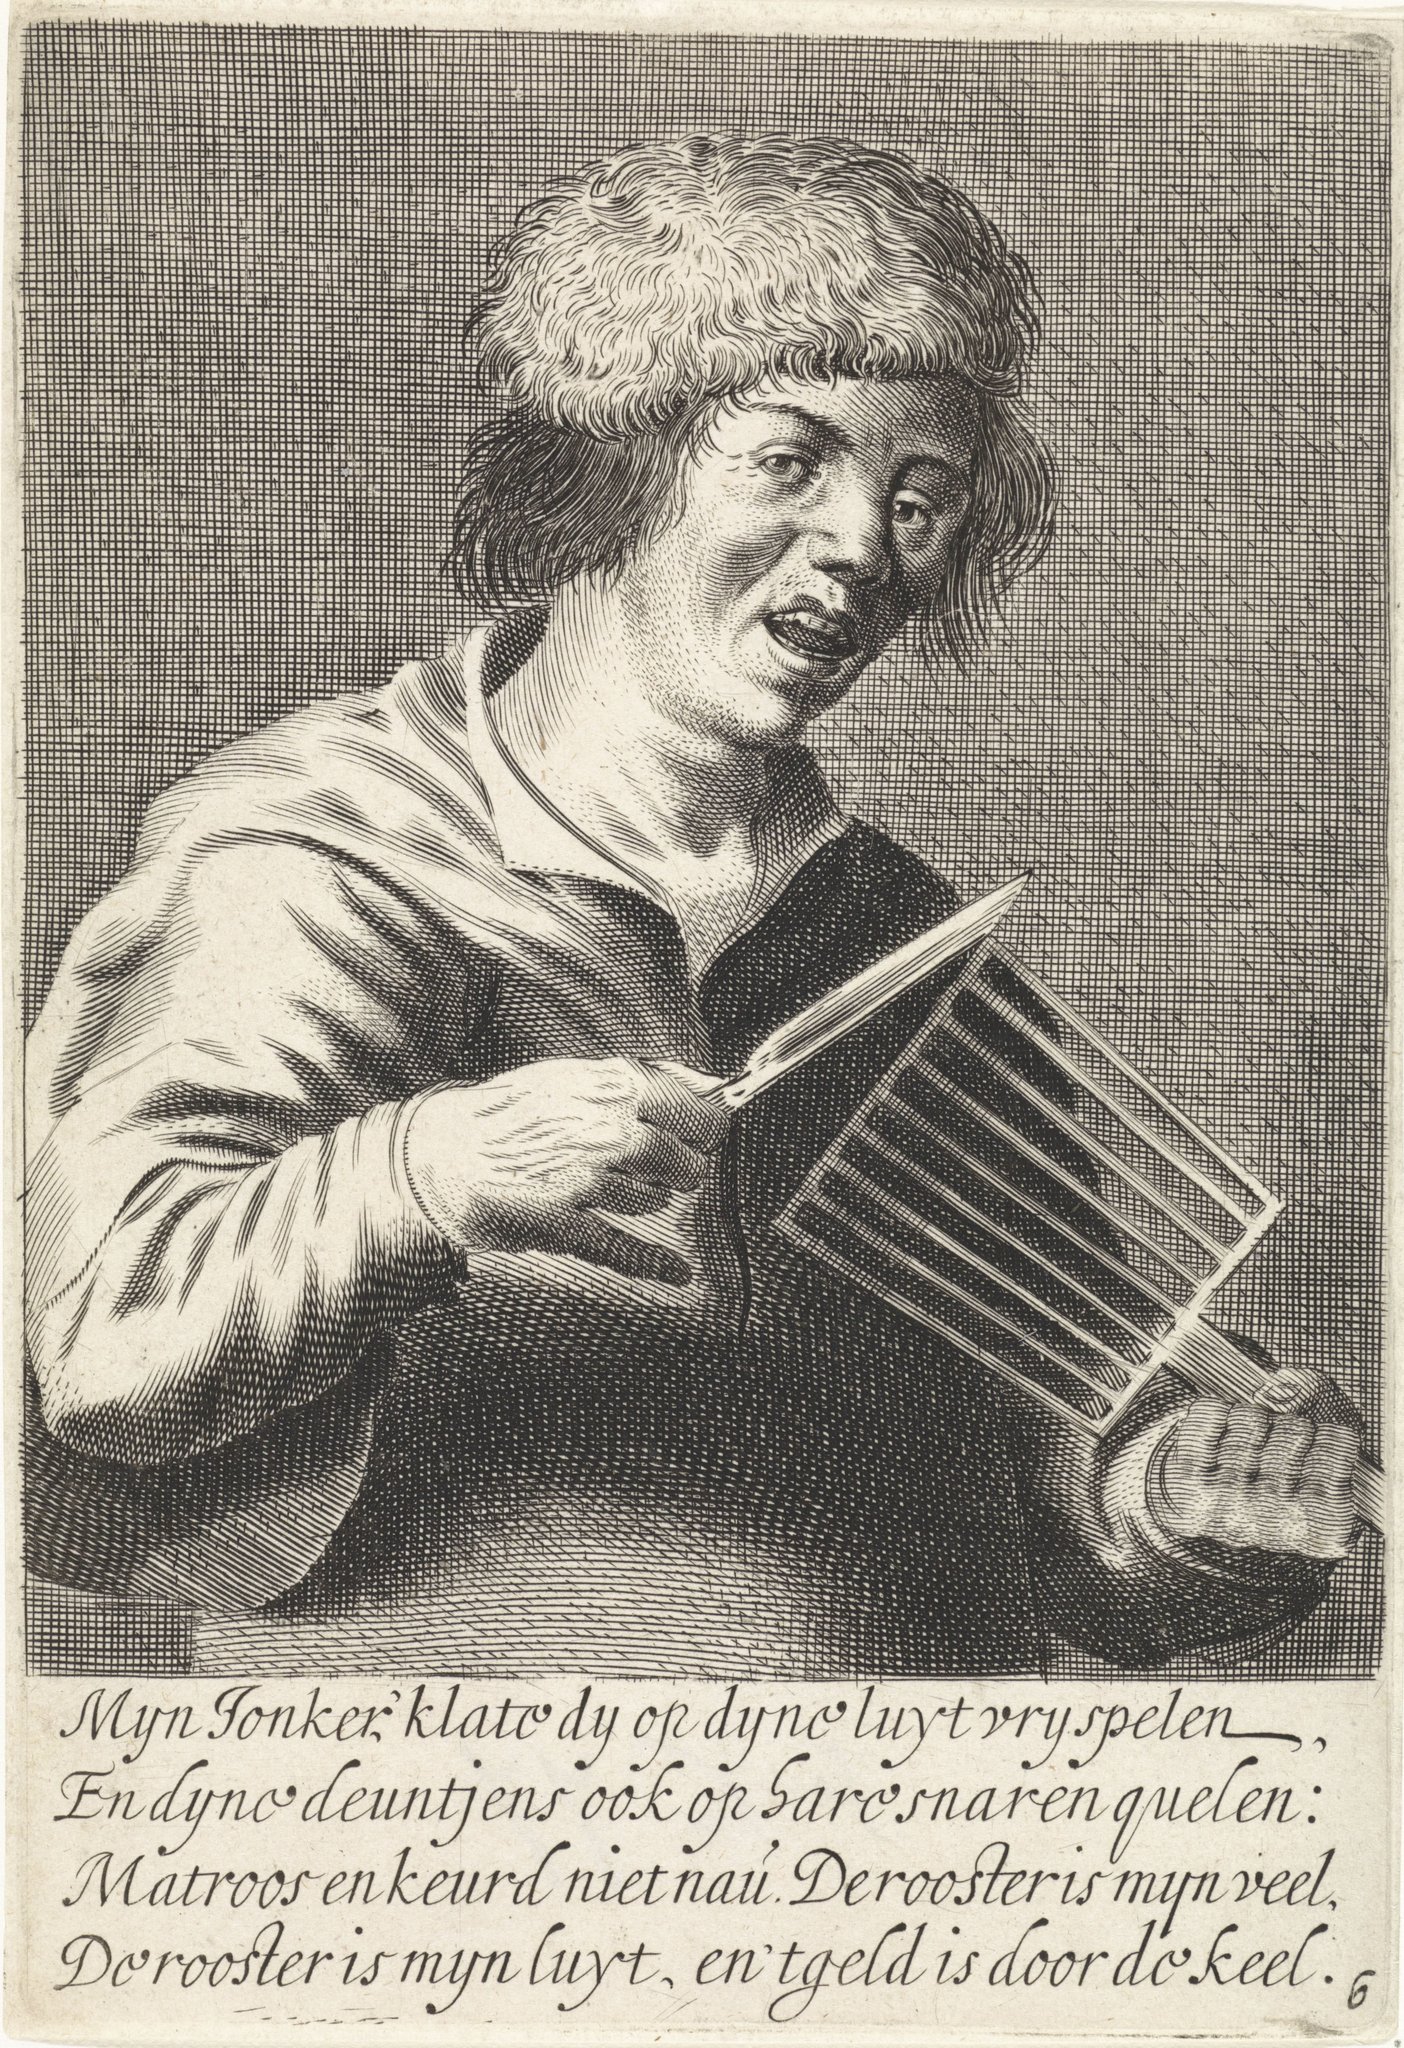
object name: print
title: Man spelend op een rooster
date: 1633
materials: paper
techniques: engraving, etching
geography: amsterdam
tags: improvised musical instruments (kitchen-utensils, etc.), the poor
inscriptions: collector's mark: Lugt 240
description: Een arme man bespeelt keukengerei alsof het een muziekintsrument is. Zesde prent uit een serie van achttien.